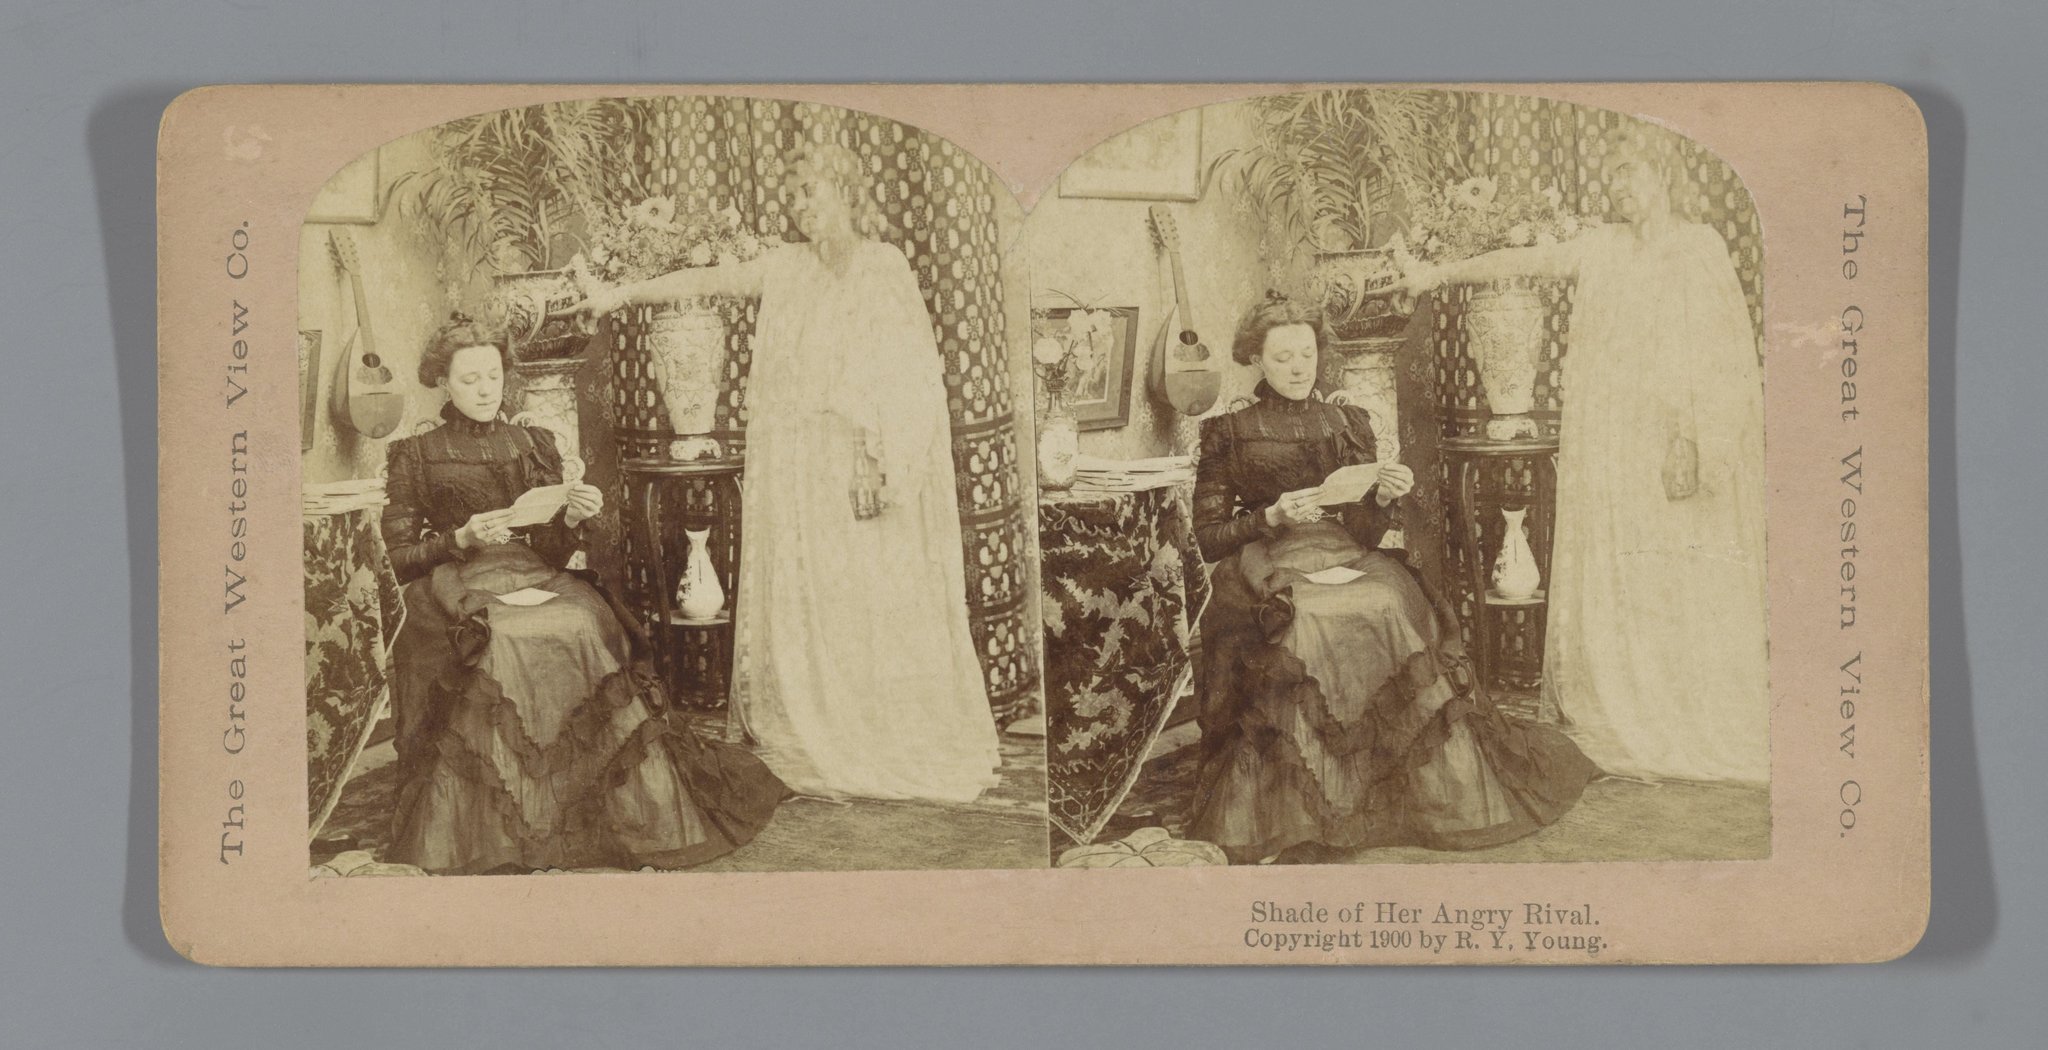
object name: stereograph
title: Shade of Her Angry Rival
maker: roddo y. young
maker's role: publisher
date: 1900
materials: cardboard, photographic support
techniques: albumen print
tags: spirit, ghost, letter, envelope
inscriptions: monogram: ‘JK’, name: ‘Copyright 1900 by R.Y. Young’